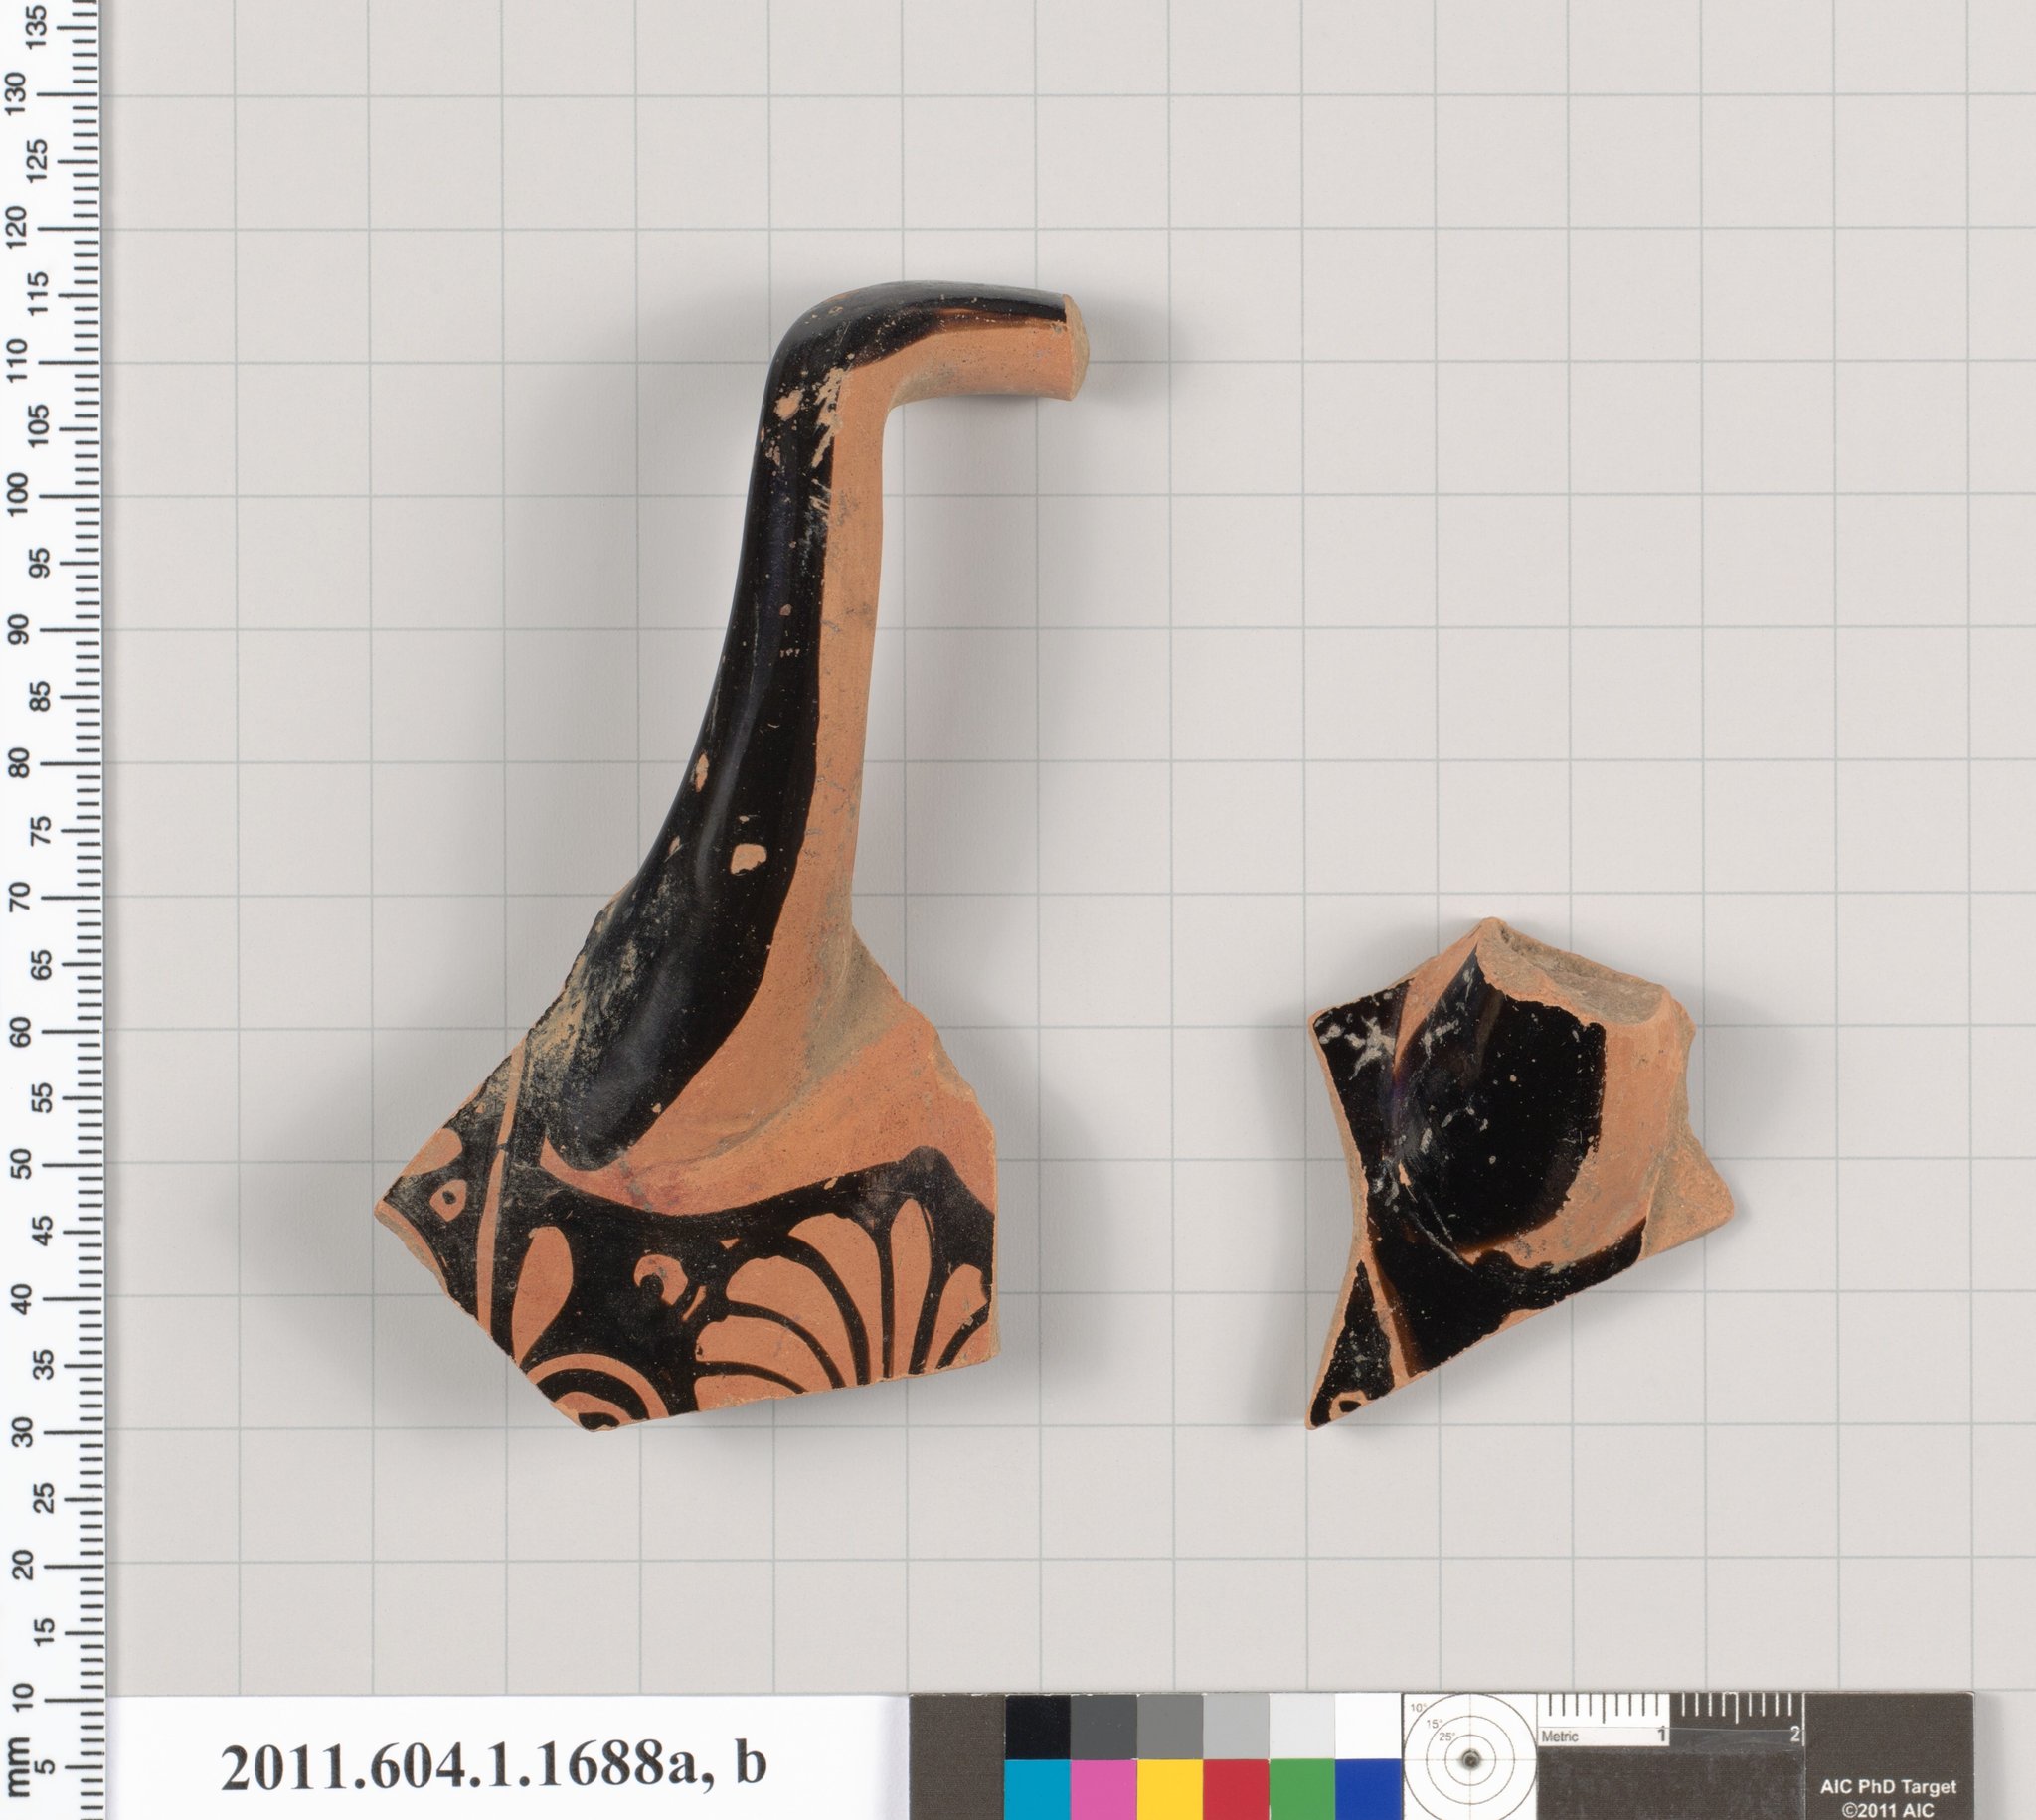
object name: kylix fragment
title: Terracotta fragments of kylikes (drinking cups)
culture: greek, attic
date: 500-401 BCE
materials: terracotta